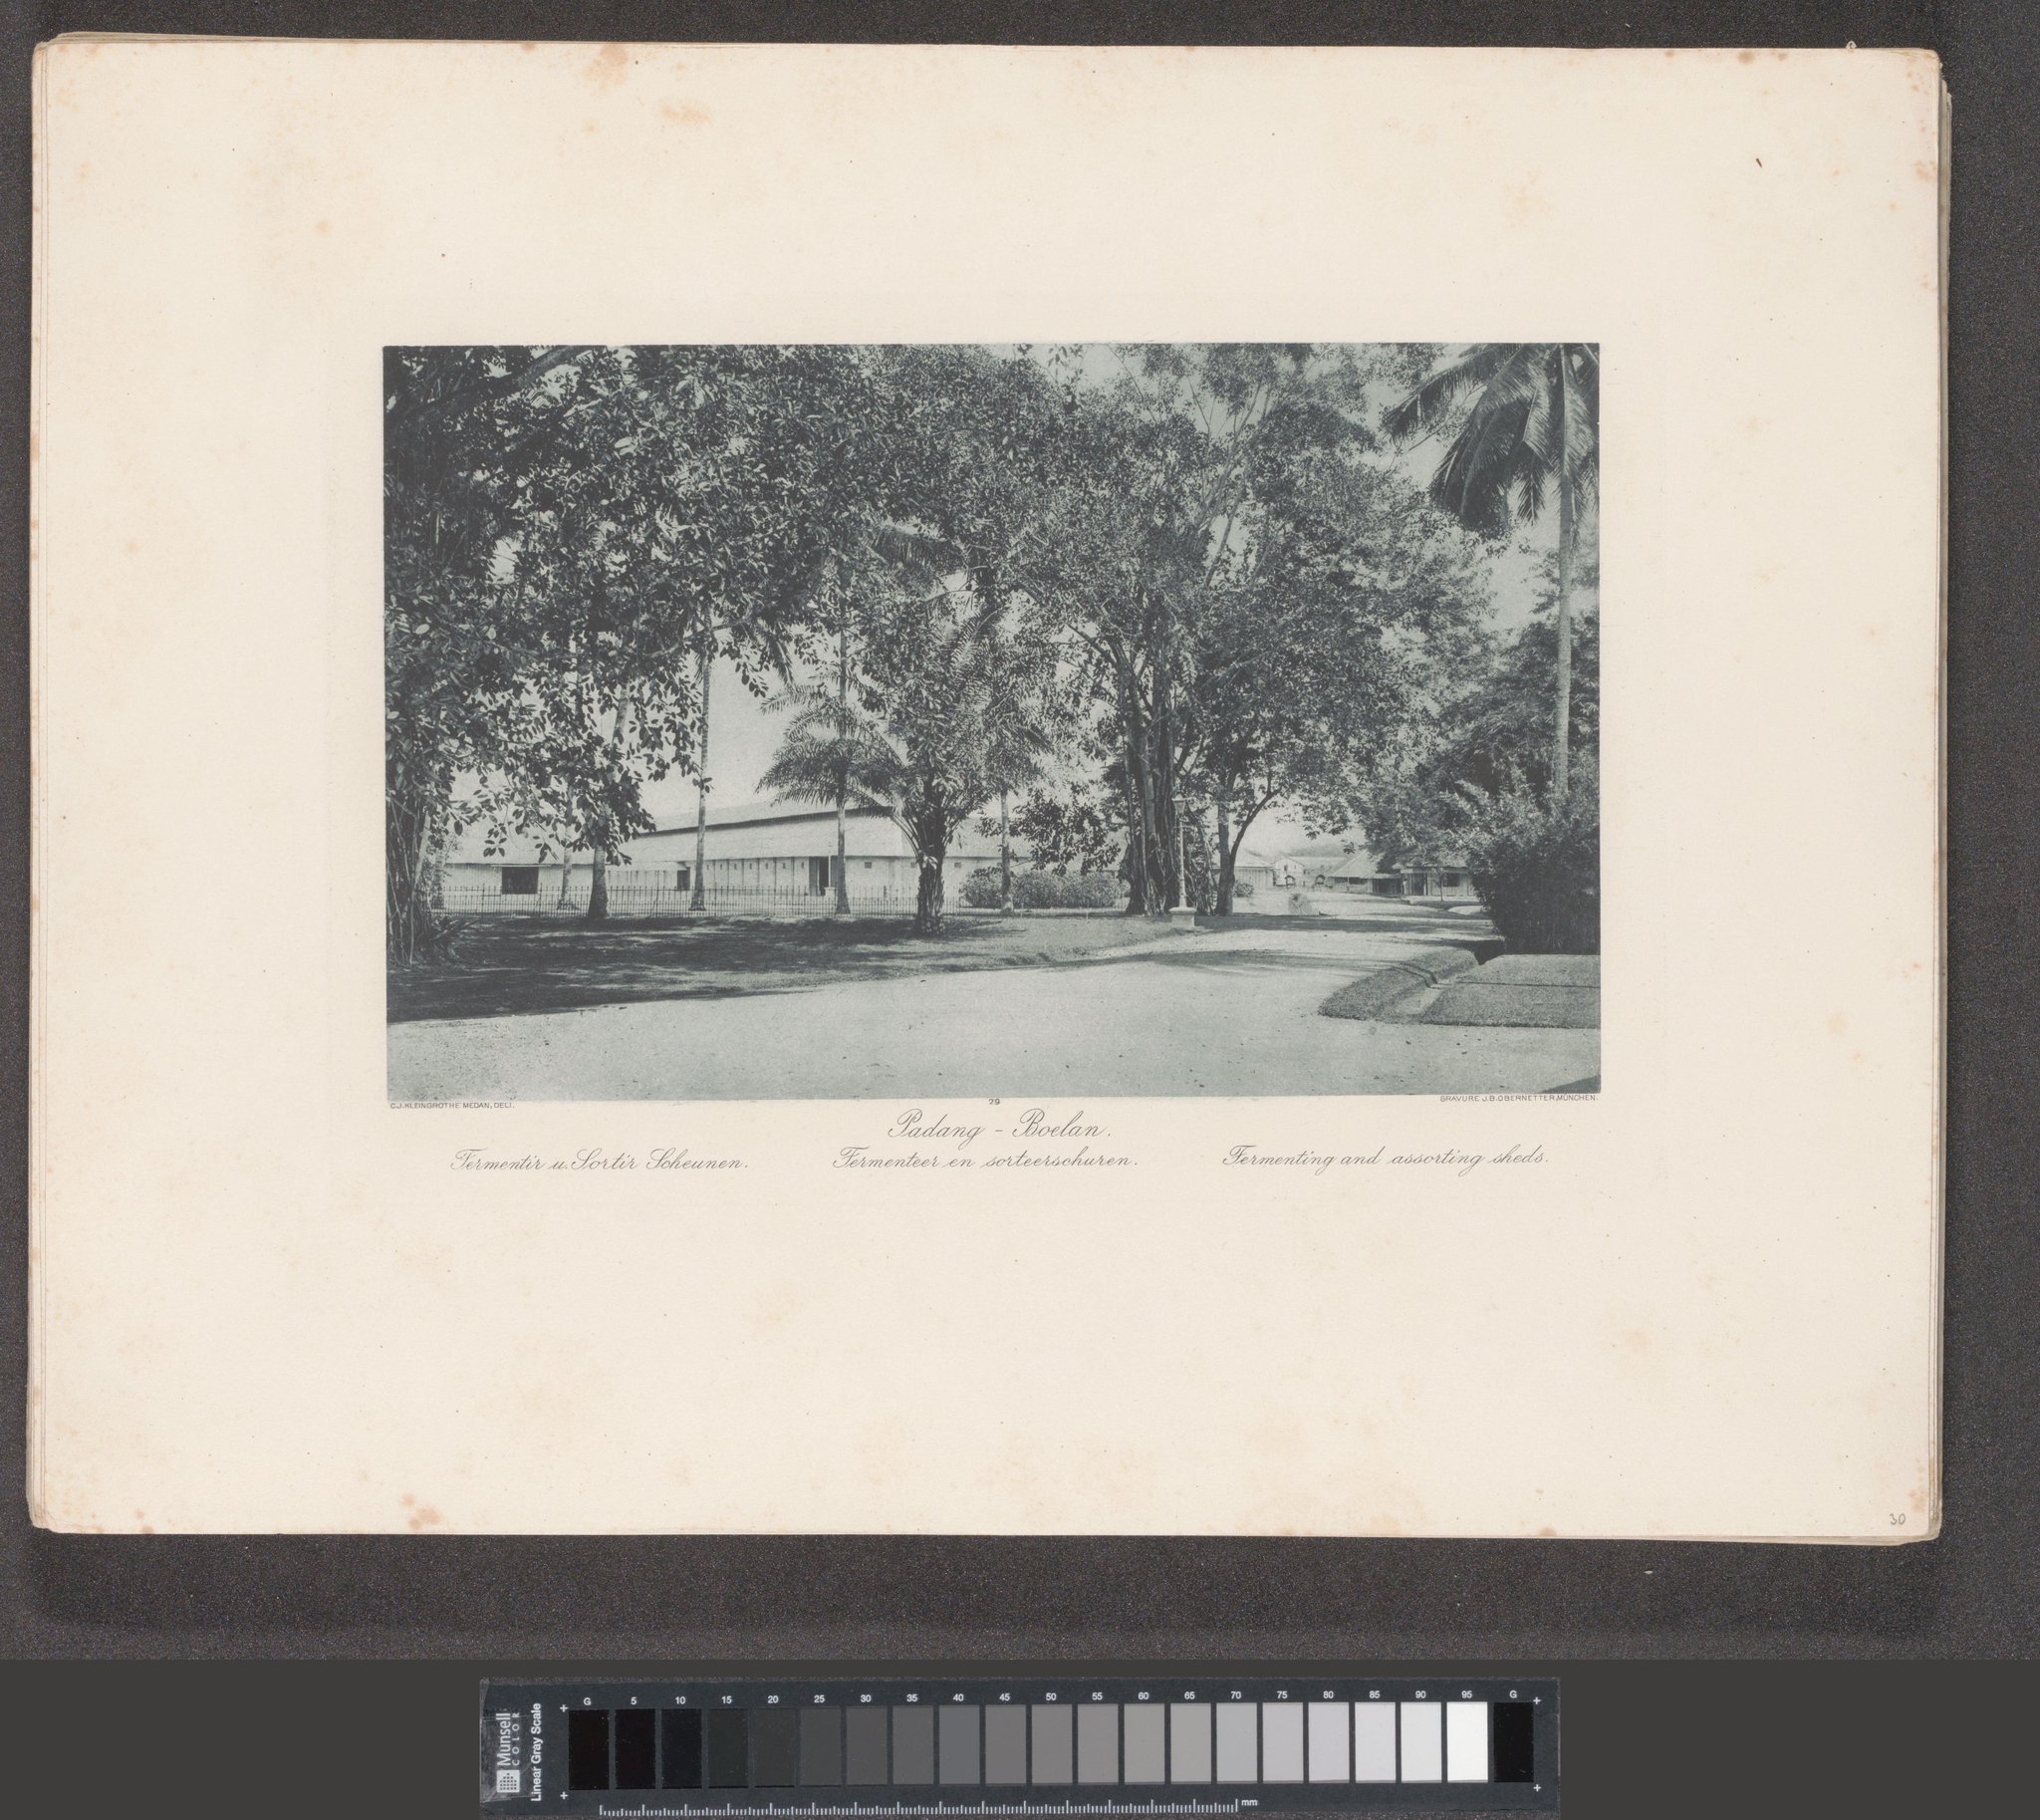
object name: photomechanical print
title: Padang - Boelan Fermenteer en sorteerschuren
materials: paper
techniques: photoaquatint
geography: munich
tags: plantation, barn, tobacco, sumatra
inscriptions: number: ‘29’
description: Onderdeel van Album met heliogravures van Sumatra's oostkust.